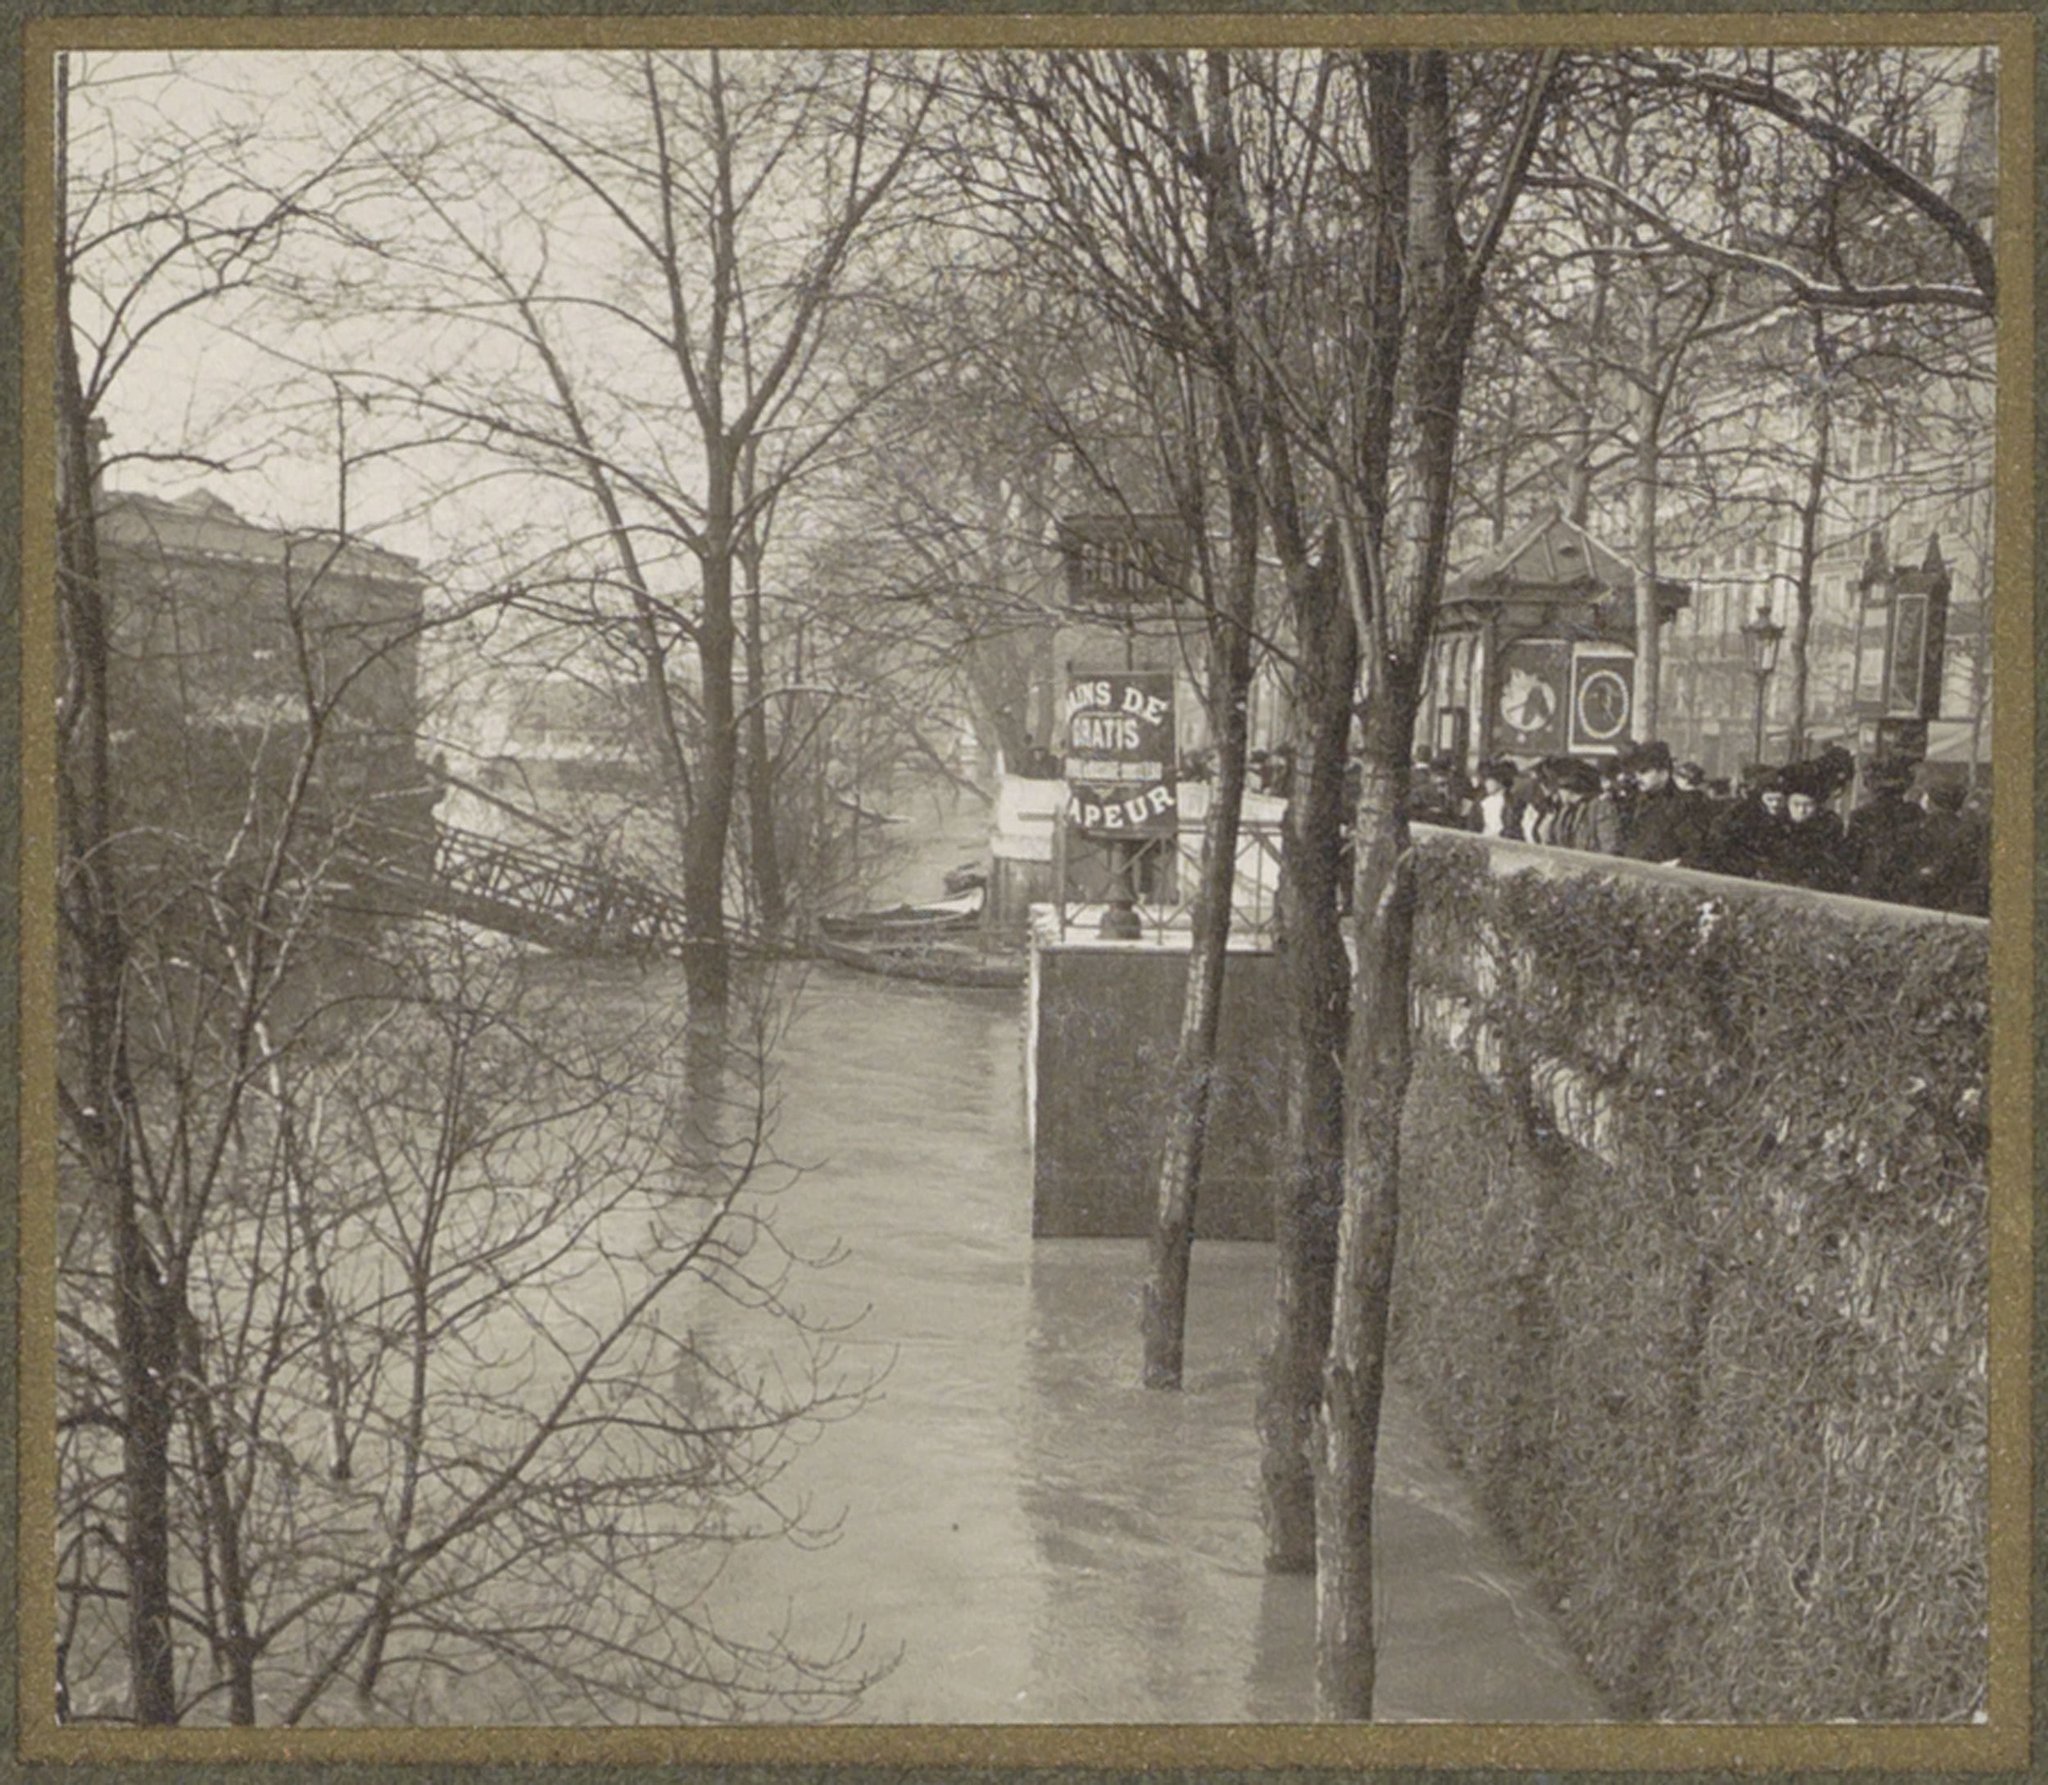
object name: photograph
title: Mensen bekijken vanaf de kade de hoge waterstand van de Seine in Parijs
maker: g. dangereux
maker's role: fotograaf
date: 1901-1910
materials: photographic support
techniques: matte daylight collodion silver print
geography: paris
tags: flood (+ landscape with figures, staffage), pier, quay, wharf, paris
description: Onderdeel van fotoalbum overstroming Parijs en voorsteden 1910.